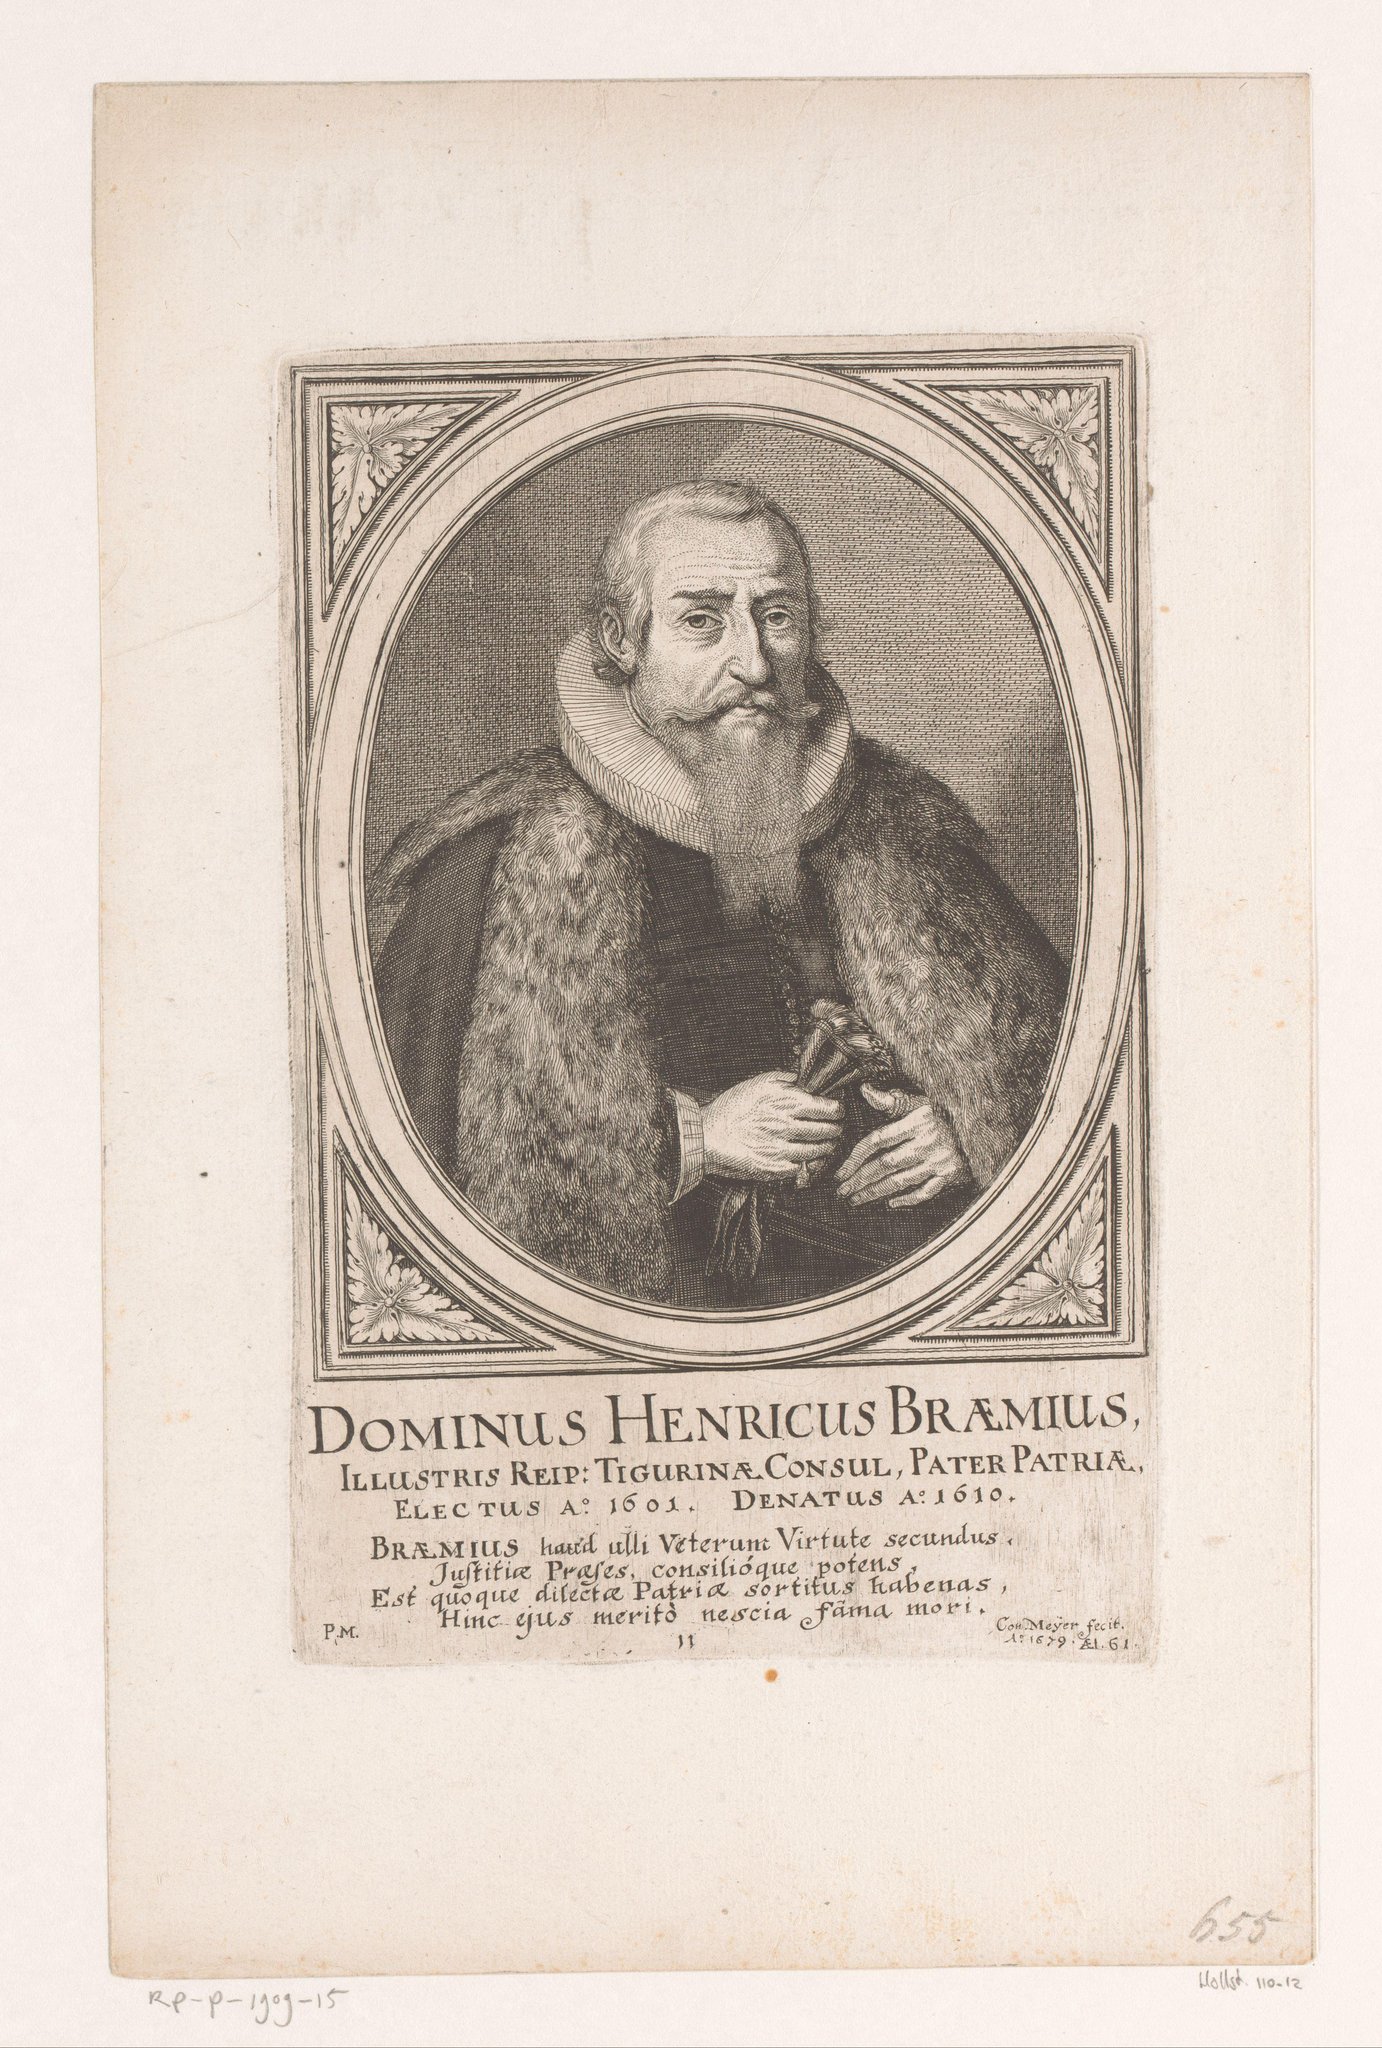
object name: print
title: Portret van Henricus Braemius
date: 1679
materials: paper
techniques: engraving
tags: gloves, mittens, etc., historical persons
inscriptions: collector's mark: Lugt 2228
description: Onderdeel van een serie van 67(?) portretten van burgemeesters van Zürich. Zie Hollstein German 110, 1-26.